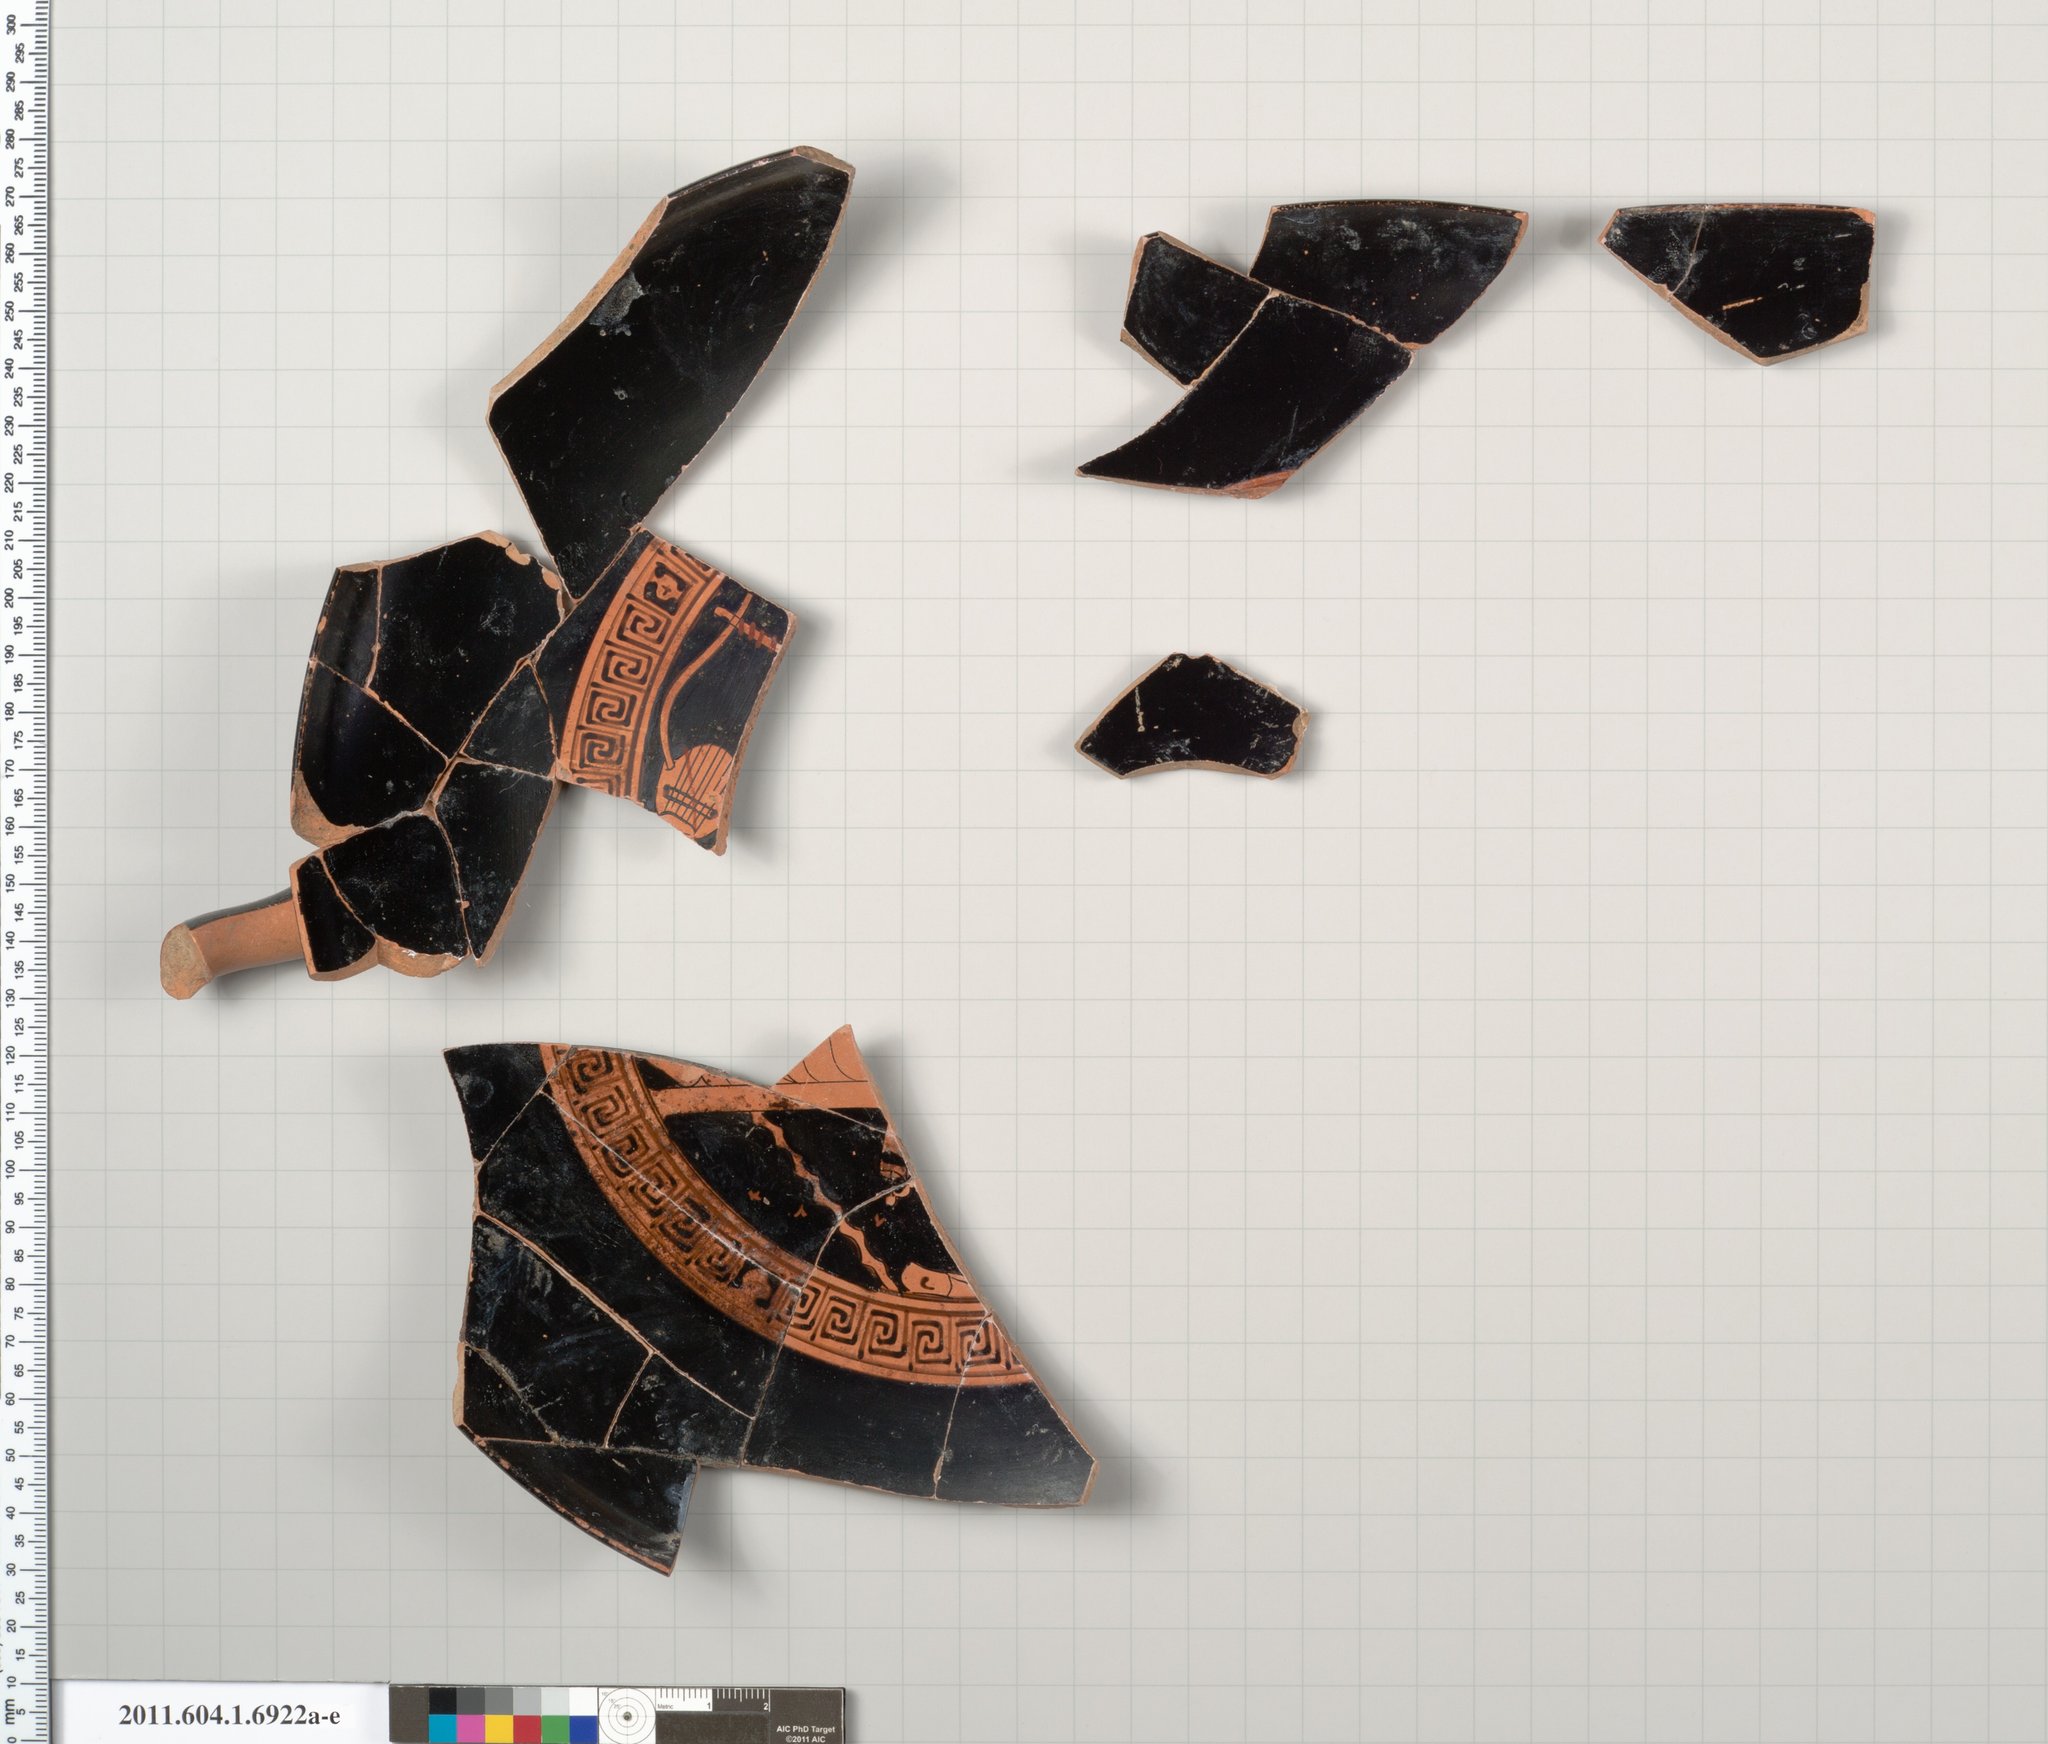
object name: kylix fragment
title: Terracotta fragments of a kylix (drinking cup)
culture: greek, attic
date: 490-470 BCE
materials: terracotta